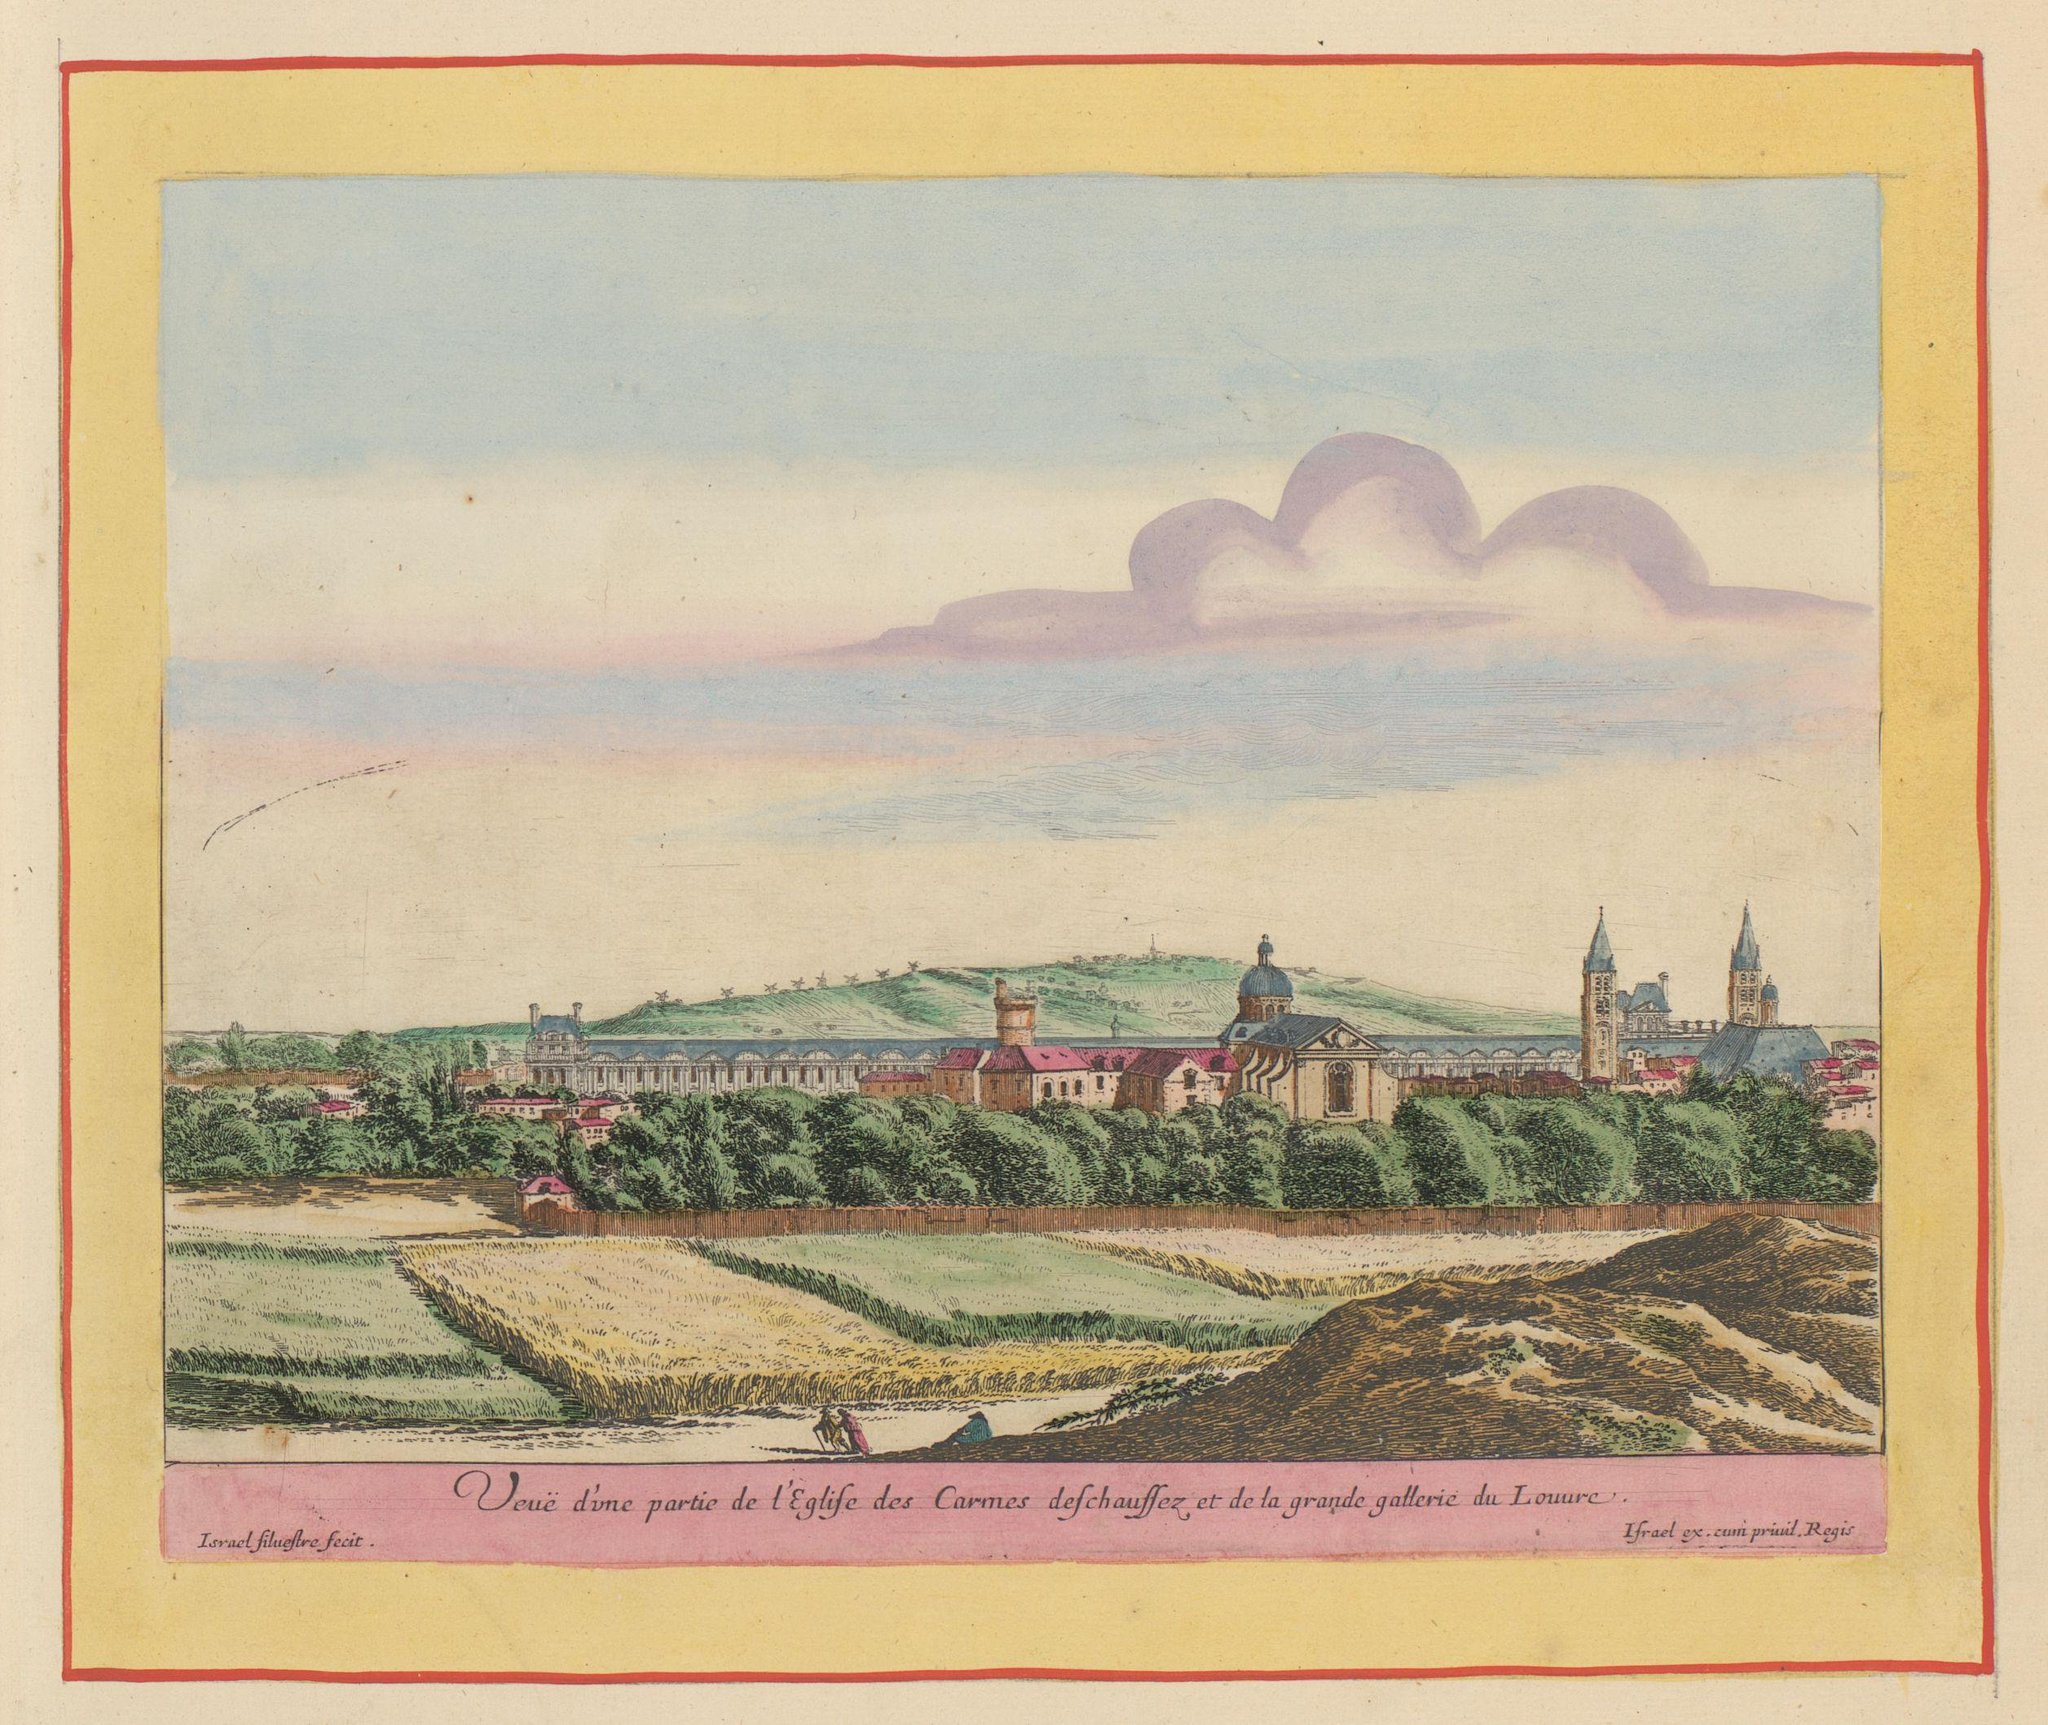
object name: print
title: Veuë d'une partie de l'Eglise des Carmes deschaussez et de la grande gallerie du Louvre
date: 1631-1661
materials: paper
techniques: etching, hand coloring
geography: paris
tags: palace, church (exterior)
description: Landschap met een gezicht op de kerk Saint-Joseph-des-Carmes en de Grande Galerie van het Palais du Louvre te Parijs. Prent maakt deel uit van een album.